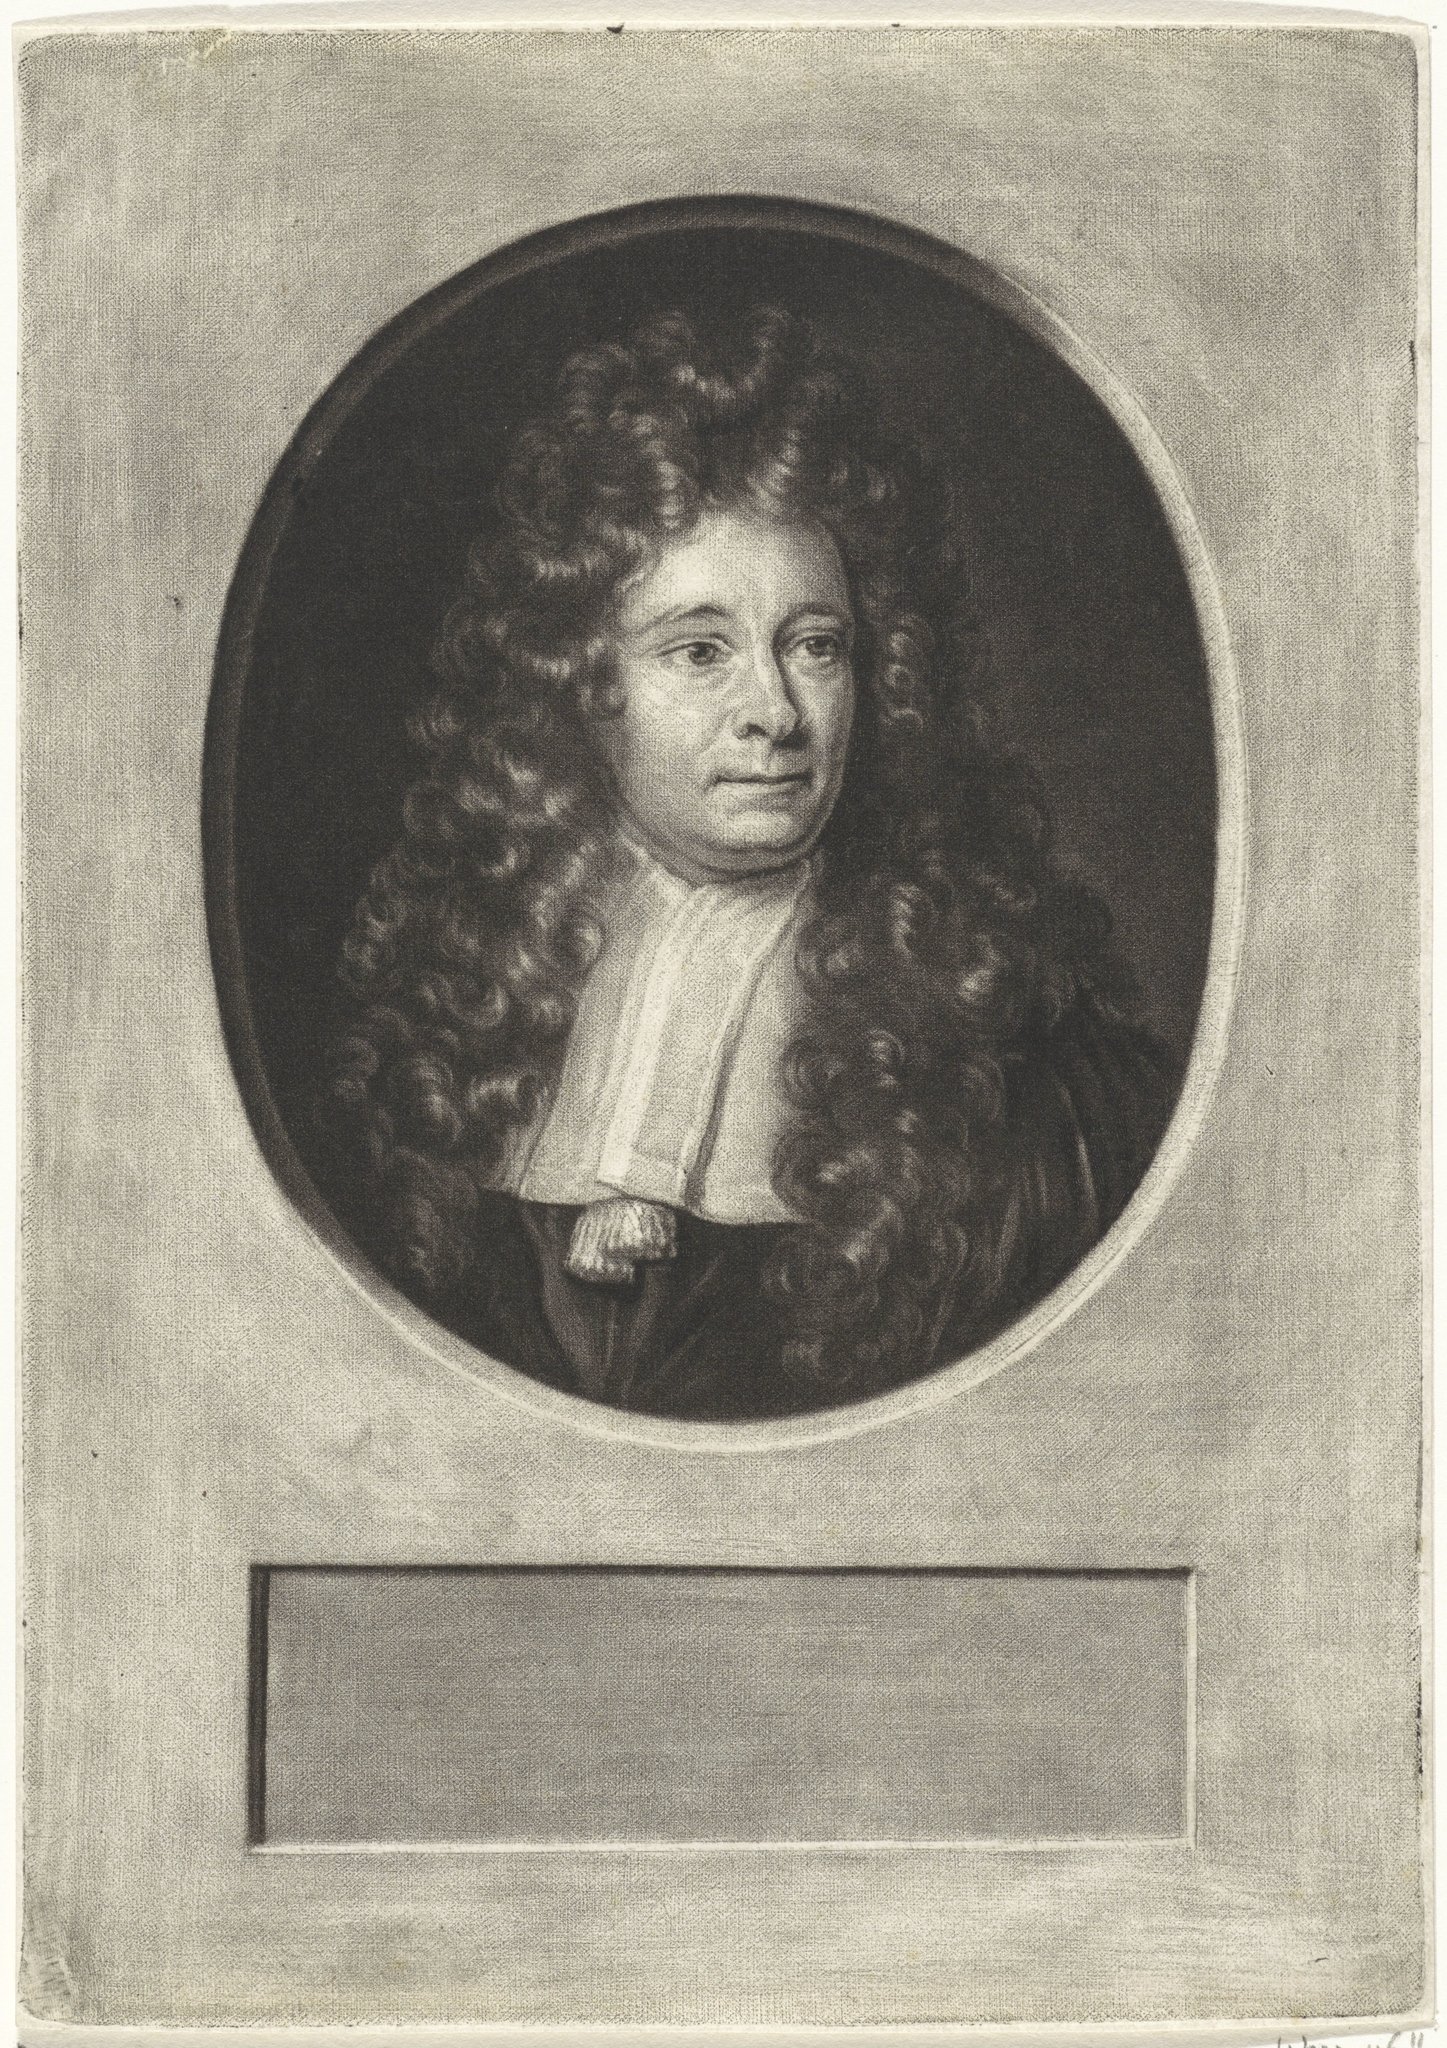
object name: print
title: Portret van Steven Blankaart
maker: jacob gole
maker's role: print maker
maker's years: 1660-1724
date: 1670-1724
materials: paper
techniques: mezzotint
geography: amsterdam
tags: middelburg, wig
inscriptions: collector's mark: Lugt 2228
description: Steven Blankaart, Nederlands dichter en geneesheer te Amsterdam.